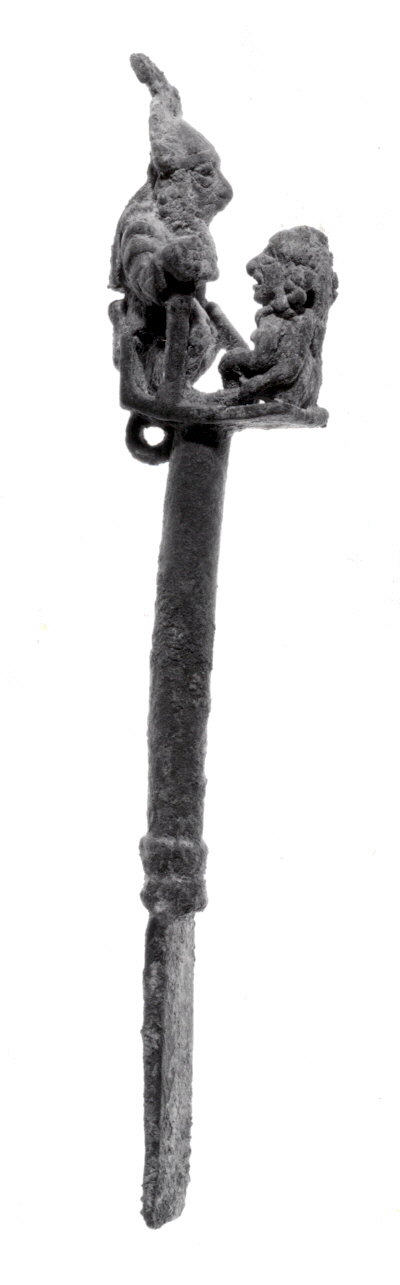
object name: knife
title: Ceremonial Knife (Tumi)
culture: moche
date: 101-700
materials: copper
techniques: casting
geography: peru